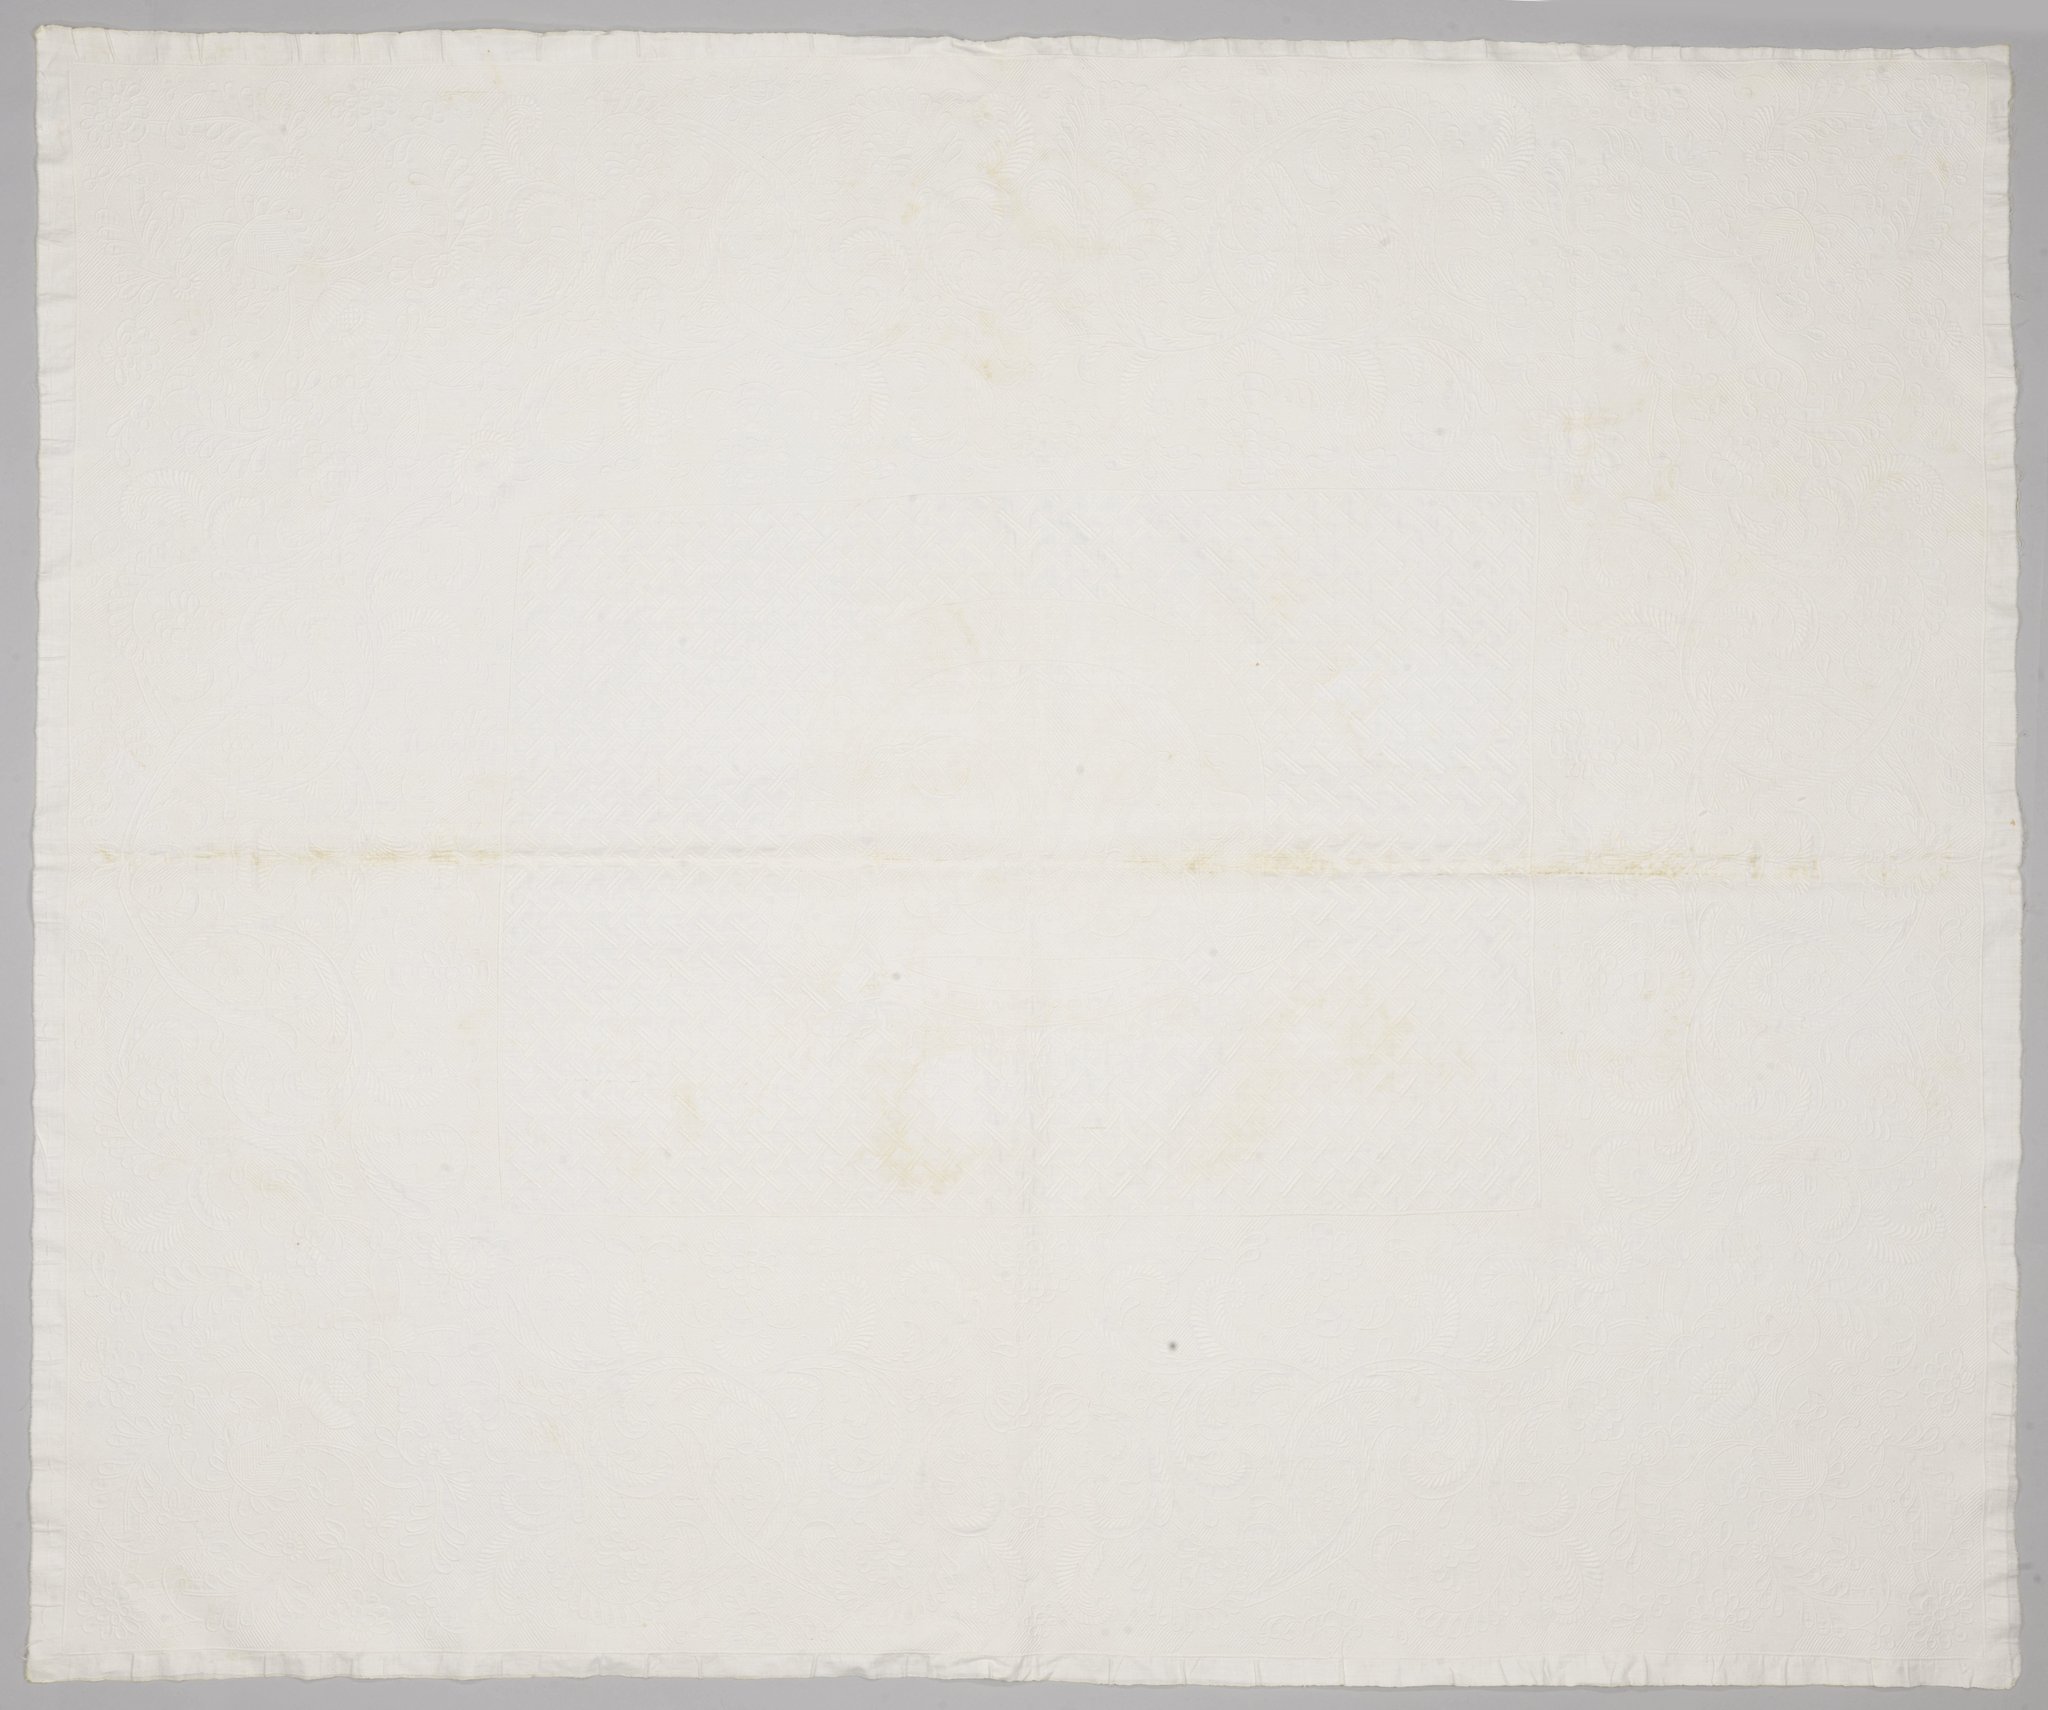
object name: kleed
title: Toiletkleed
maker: Anonymous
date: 1723-1769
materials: cotton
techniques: embroidered, quilting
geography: northern netherlands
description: Toiletkleed van Zaans stikwerk met gekroond spiegelmonogram DLWG, het motto 'ausi vertueuse que noble', een vlechtwerkpatroon en randen met voluten en bloemen.